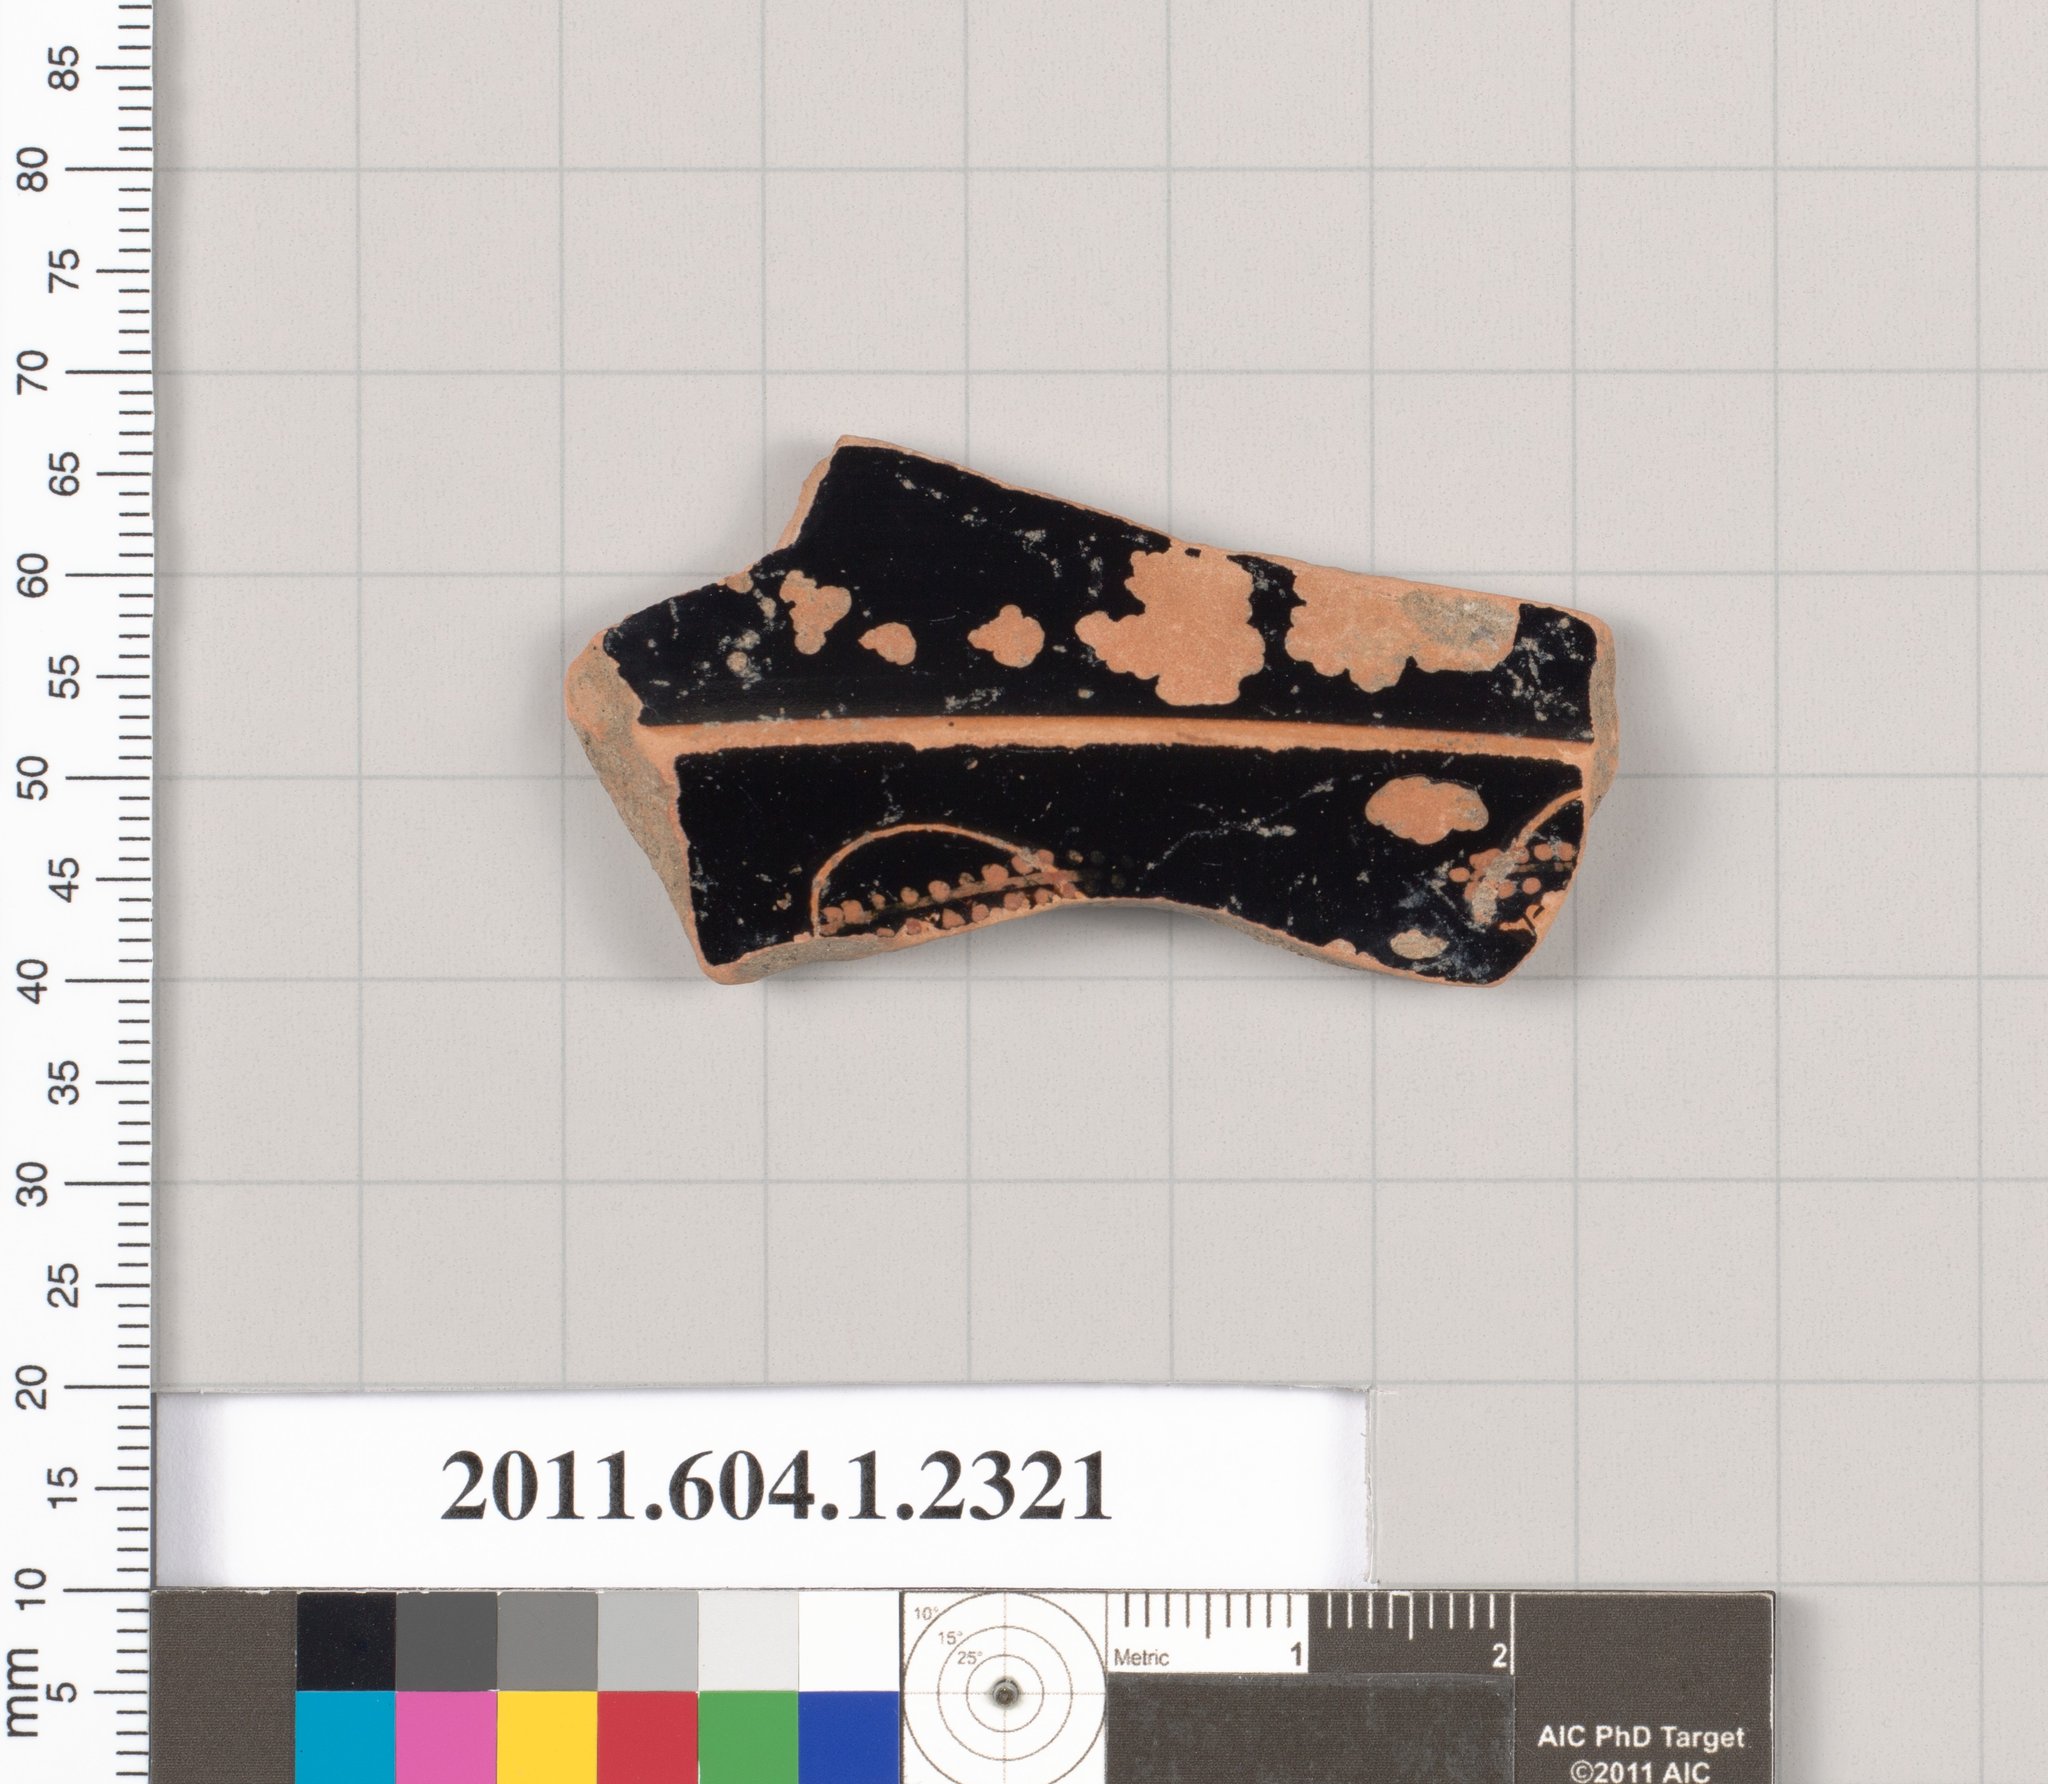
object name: kylix fragment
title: Terracotta fragment of a kylix (drinking cup)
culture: greek, attic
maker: carlsruhe painter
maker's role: artist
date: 475-451 BCE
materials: terracotta